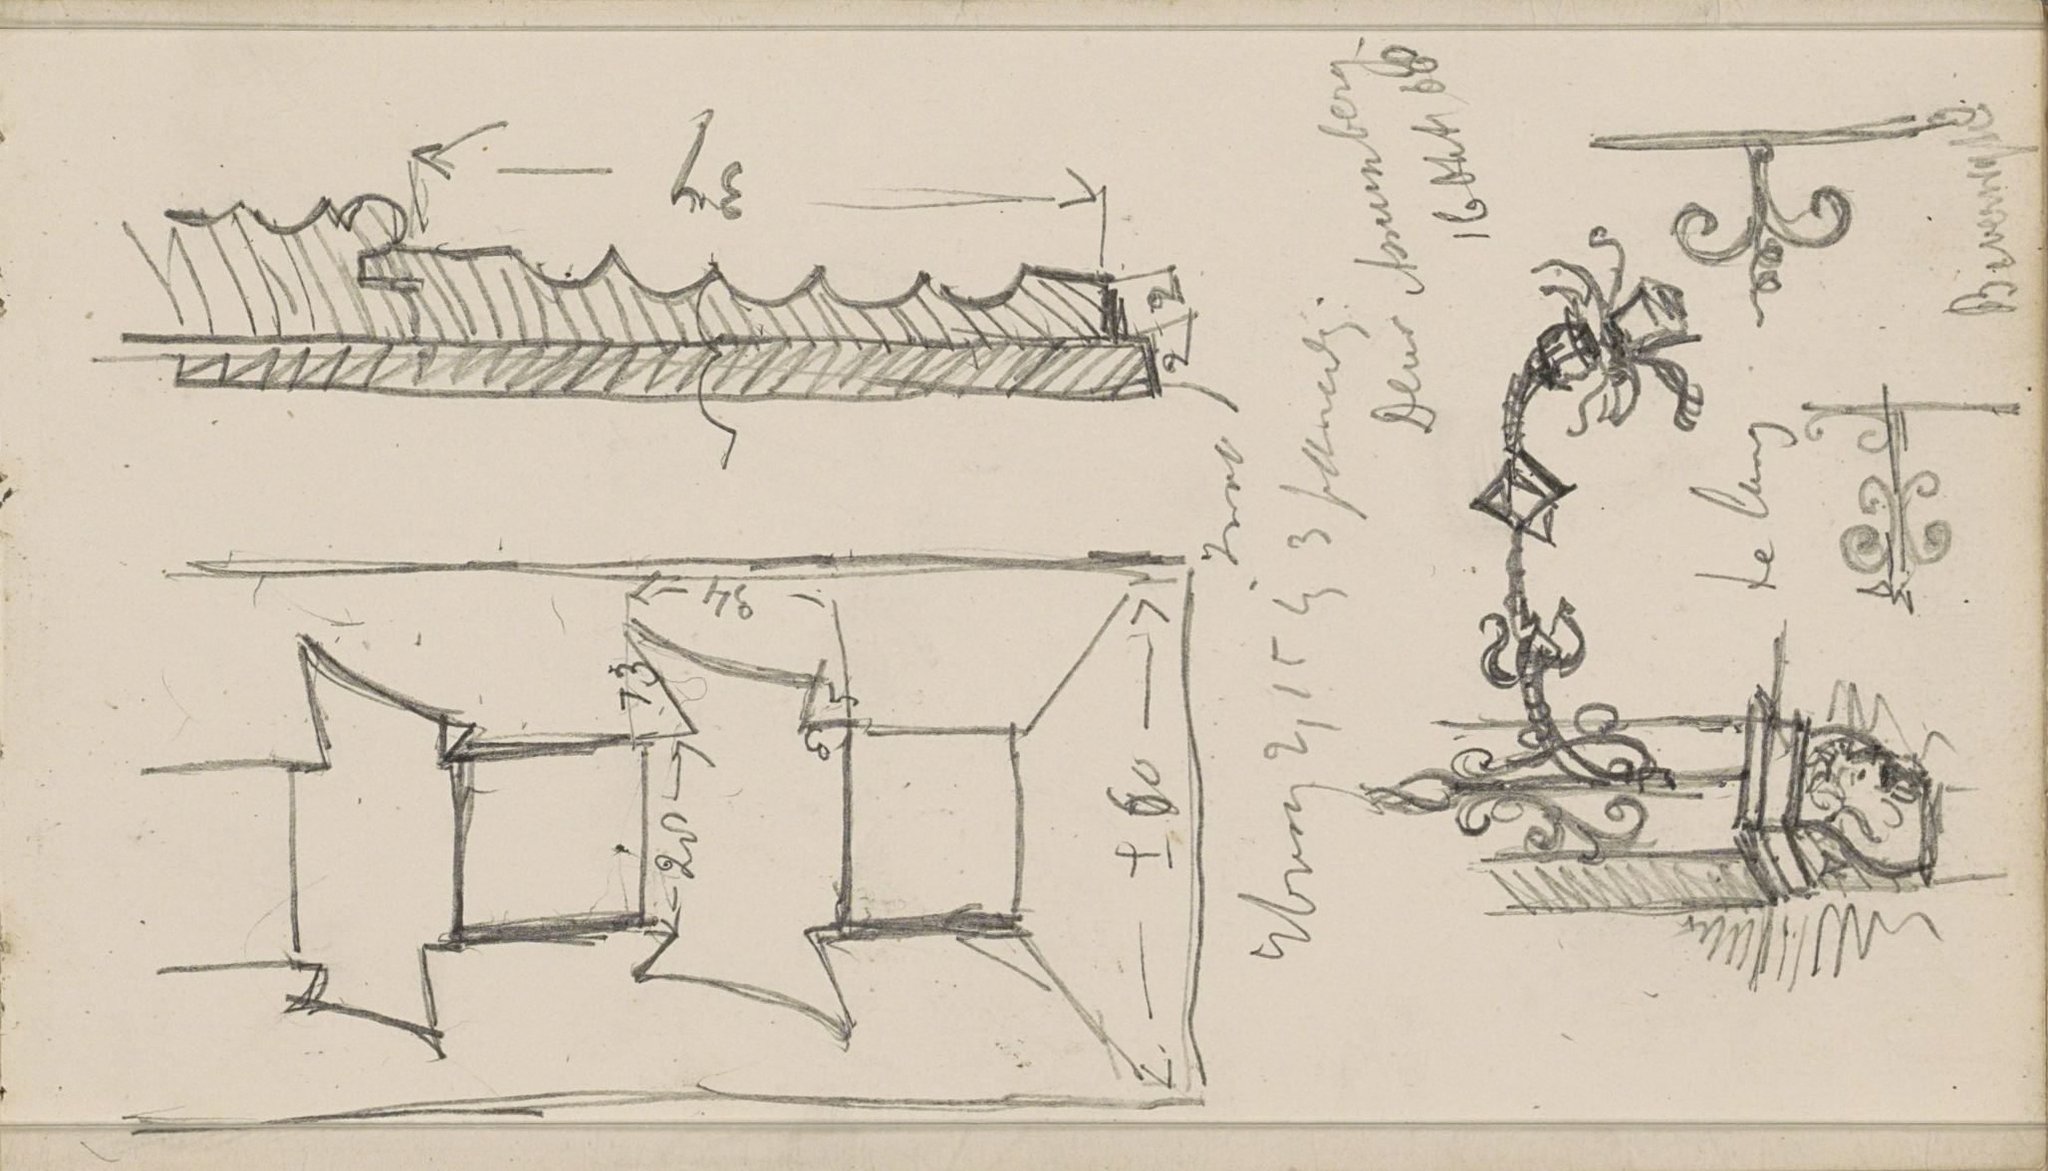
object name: sketchbook leaf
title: Deur van Kasteel Assumburg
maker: isaac gosschalk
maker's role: draughtsman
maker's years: 1838-1907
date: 1810-1868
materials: paper, pencil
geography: beverwijk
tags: door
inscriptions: date and inscription: ‘[...]/ Deur Assumburg/ 16 okt 68/ [.../ Beverwijk’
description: Tevens een studie van een console aan een gevel te Beverwijk. Blad 65 recto uit een schetsboek met 67 bladen.